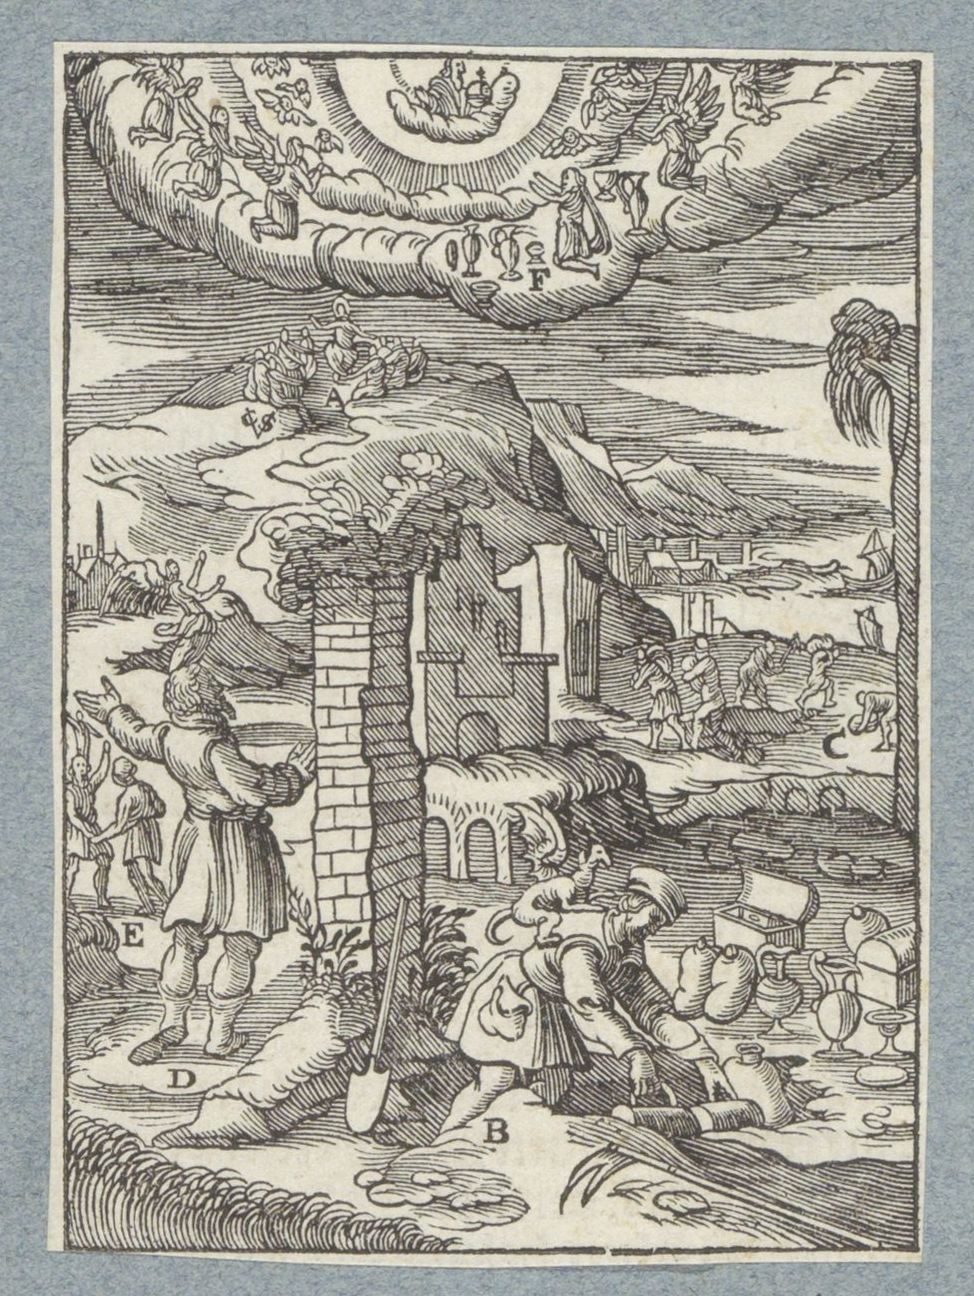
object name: album leaf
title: Huichelaar verzamelt schatten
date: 1629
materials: paper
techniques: letterpress printing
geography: amsterdam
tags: do not lay up earthly treasures ~ doctrine of christ on possessions (matthew 6:19; luke 12:21), christ's sermon on the mount (matthew 5-7)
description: De huichelaar, met een duivel boven het hoofd, begraaft zijn schatten in de aarde. De gelovige, met een engel boven het hoofd, wacht met het verzamelen van schatten tot hij in de hemel is. Uitbeelding van Mat. 6:19-21: "Verzamel schatten in de hemel, daar vreten mot noch roest ze weg, daar breken geen dieven in om ze te stelen." Op de achtergrond de Bergrede. Bij verschillende elementen uit de voorstelling staan letters. De prent maakt deel uit van een album.